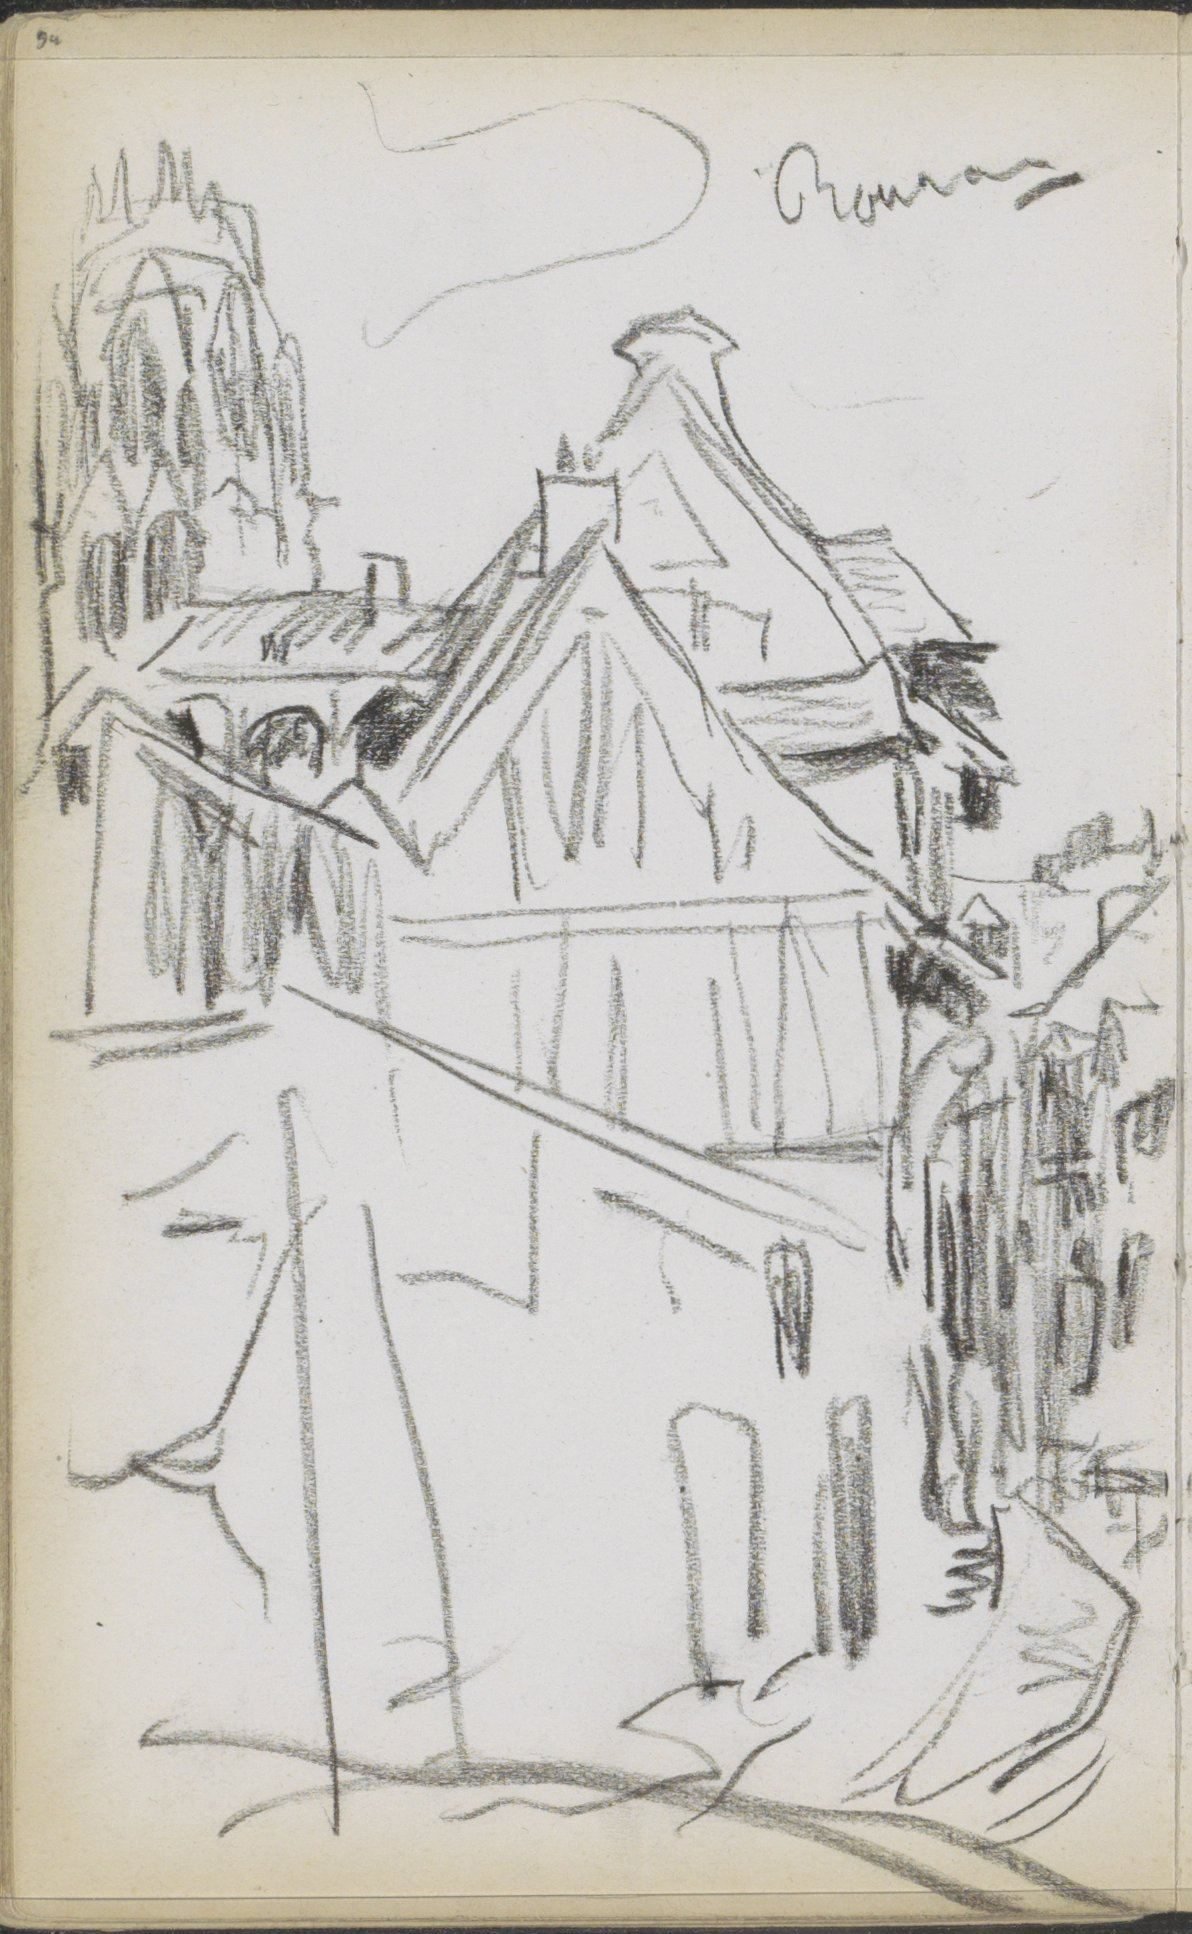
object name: sketchbook leaf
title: Straat in Parijs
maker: marius bauer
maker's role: draughtsman, print maker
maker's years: 1867-1932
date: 1810-1891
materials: chalk, paper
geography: paris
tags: architecture, street, paris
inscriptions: annotation: ‘Rou[...]’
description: Pagina 54 uit een schetsboek met 35 bladen.